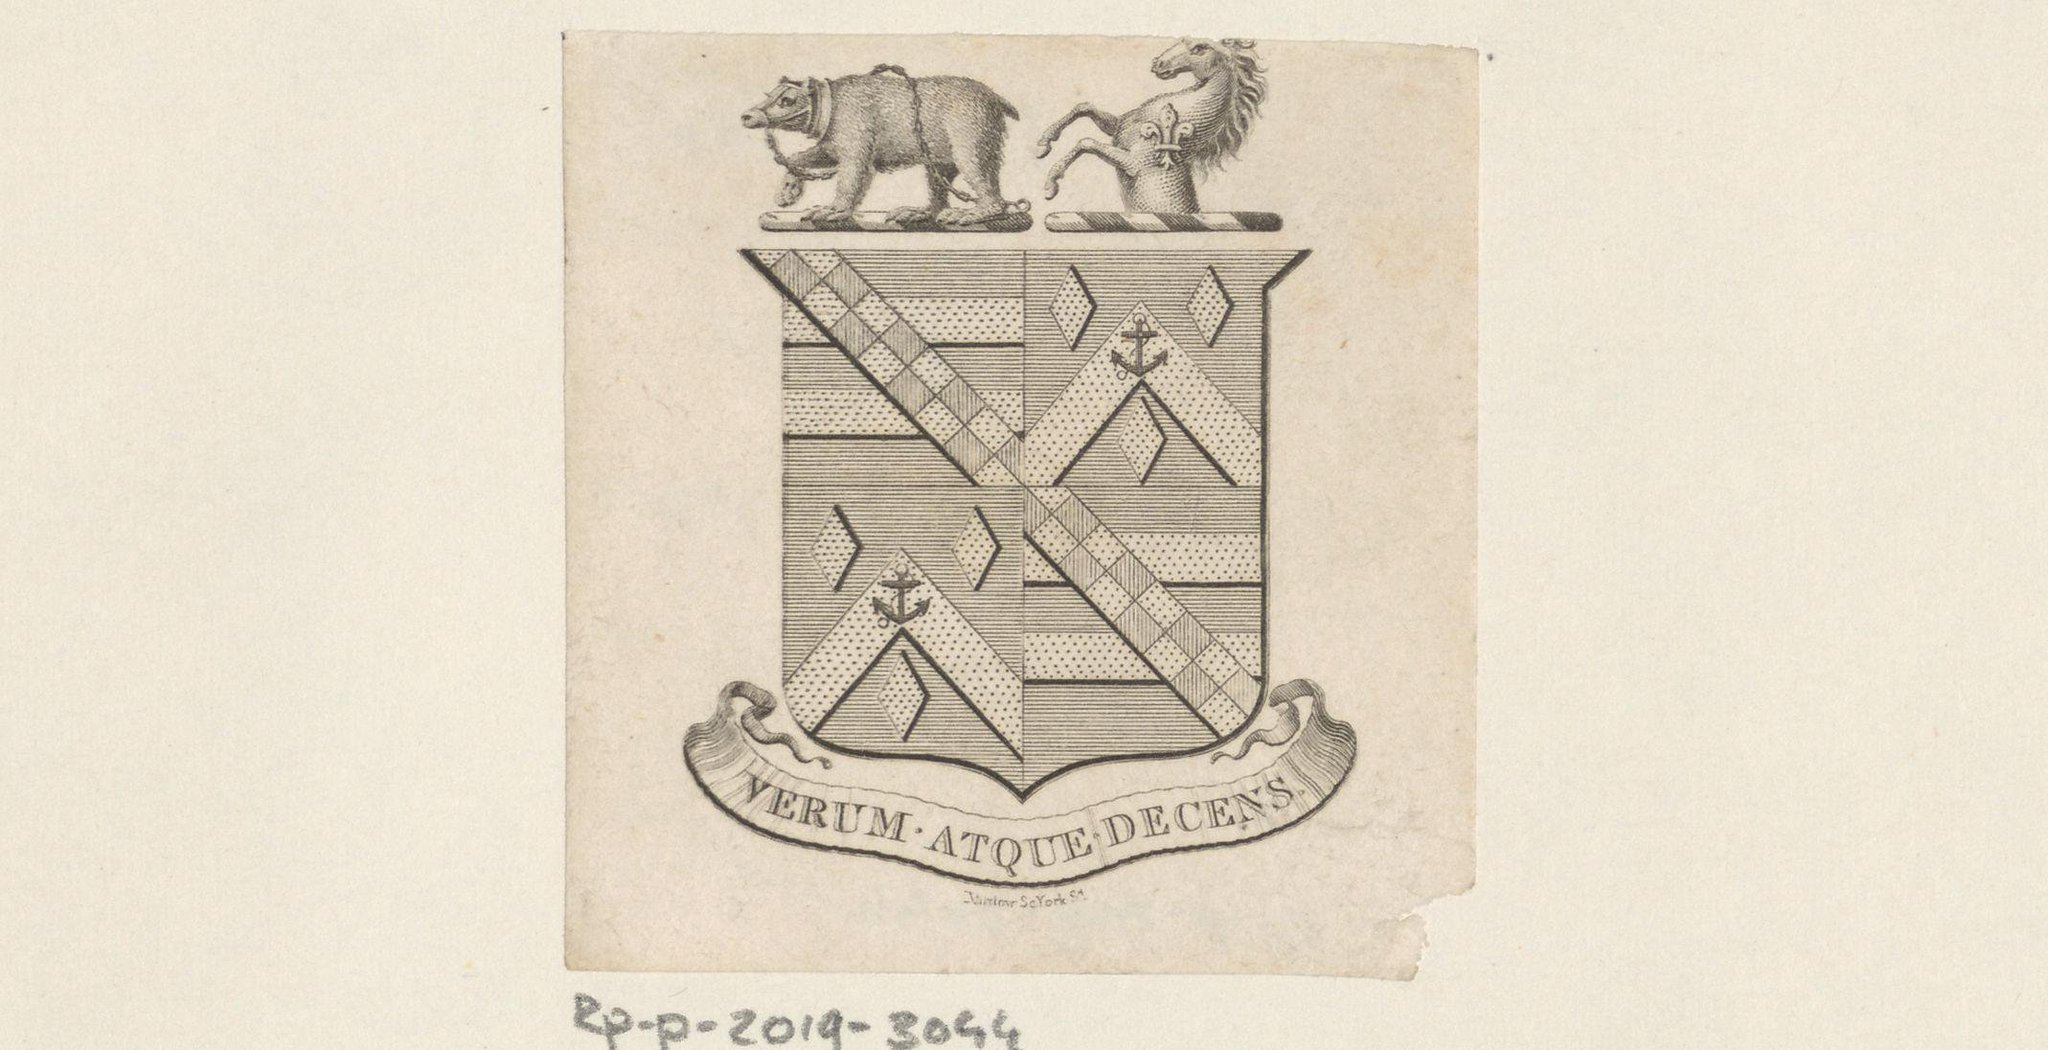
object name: bookplate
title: Ex libris van onbekend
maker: Anonymous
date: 1800-1899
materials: paper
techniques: engraving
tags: armorial bearing, heraldry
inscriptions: collector's mark: Lugt 704, collector's mark: Lugt 344